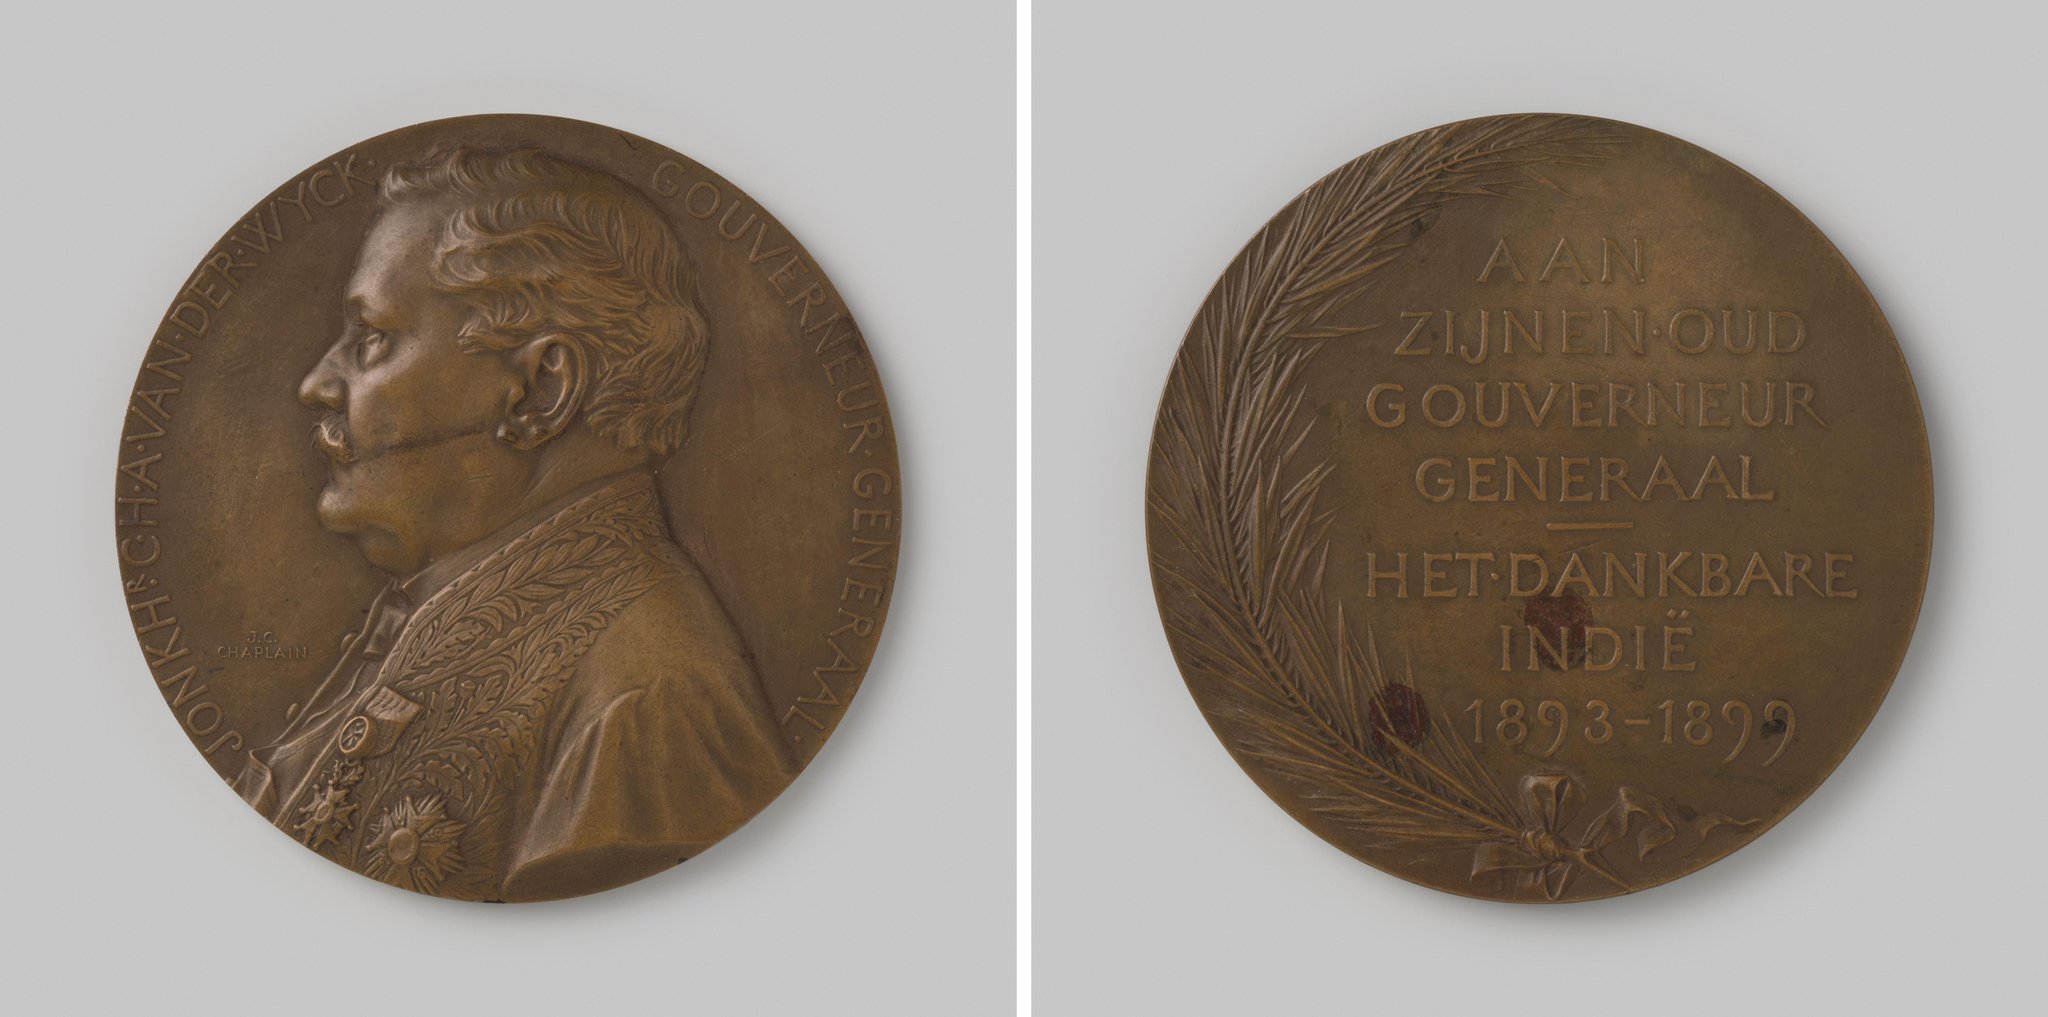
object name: history medal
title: Jhr. C.H.A. van der Wyck Gouverneur-Generaal van Nederlands Indië 1893-1899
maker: jules clement chaplain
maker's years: 1839-1909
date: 1899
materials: bronze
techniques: striking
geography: paris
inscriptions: inscription: ‘1416 - 78’, factory mark: ‘[...] BRONZE’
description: Bronzen penning, op de voorzijde het geüniformeerde borstbeeld van Van der Wyck naar links met omschrift, op de keerzijde zeven regels tekst rechts van een halfronde palmtak met strik.